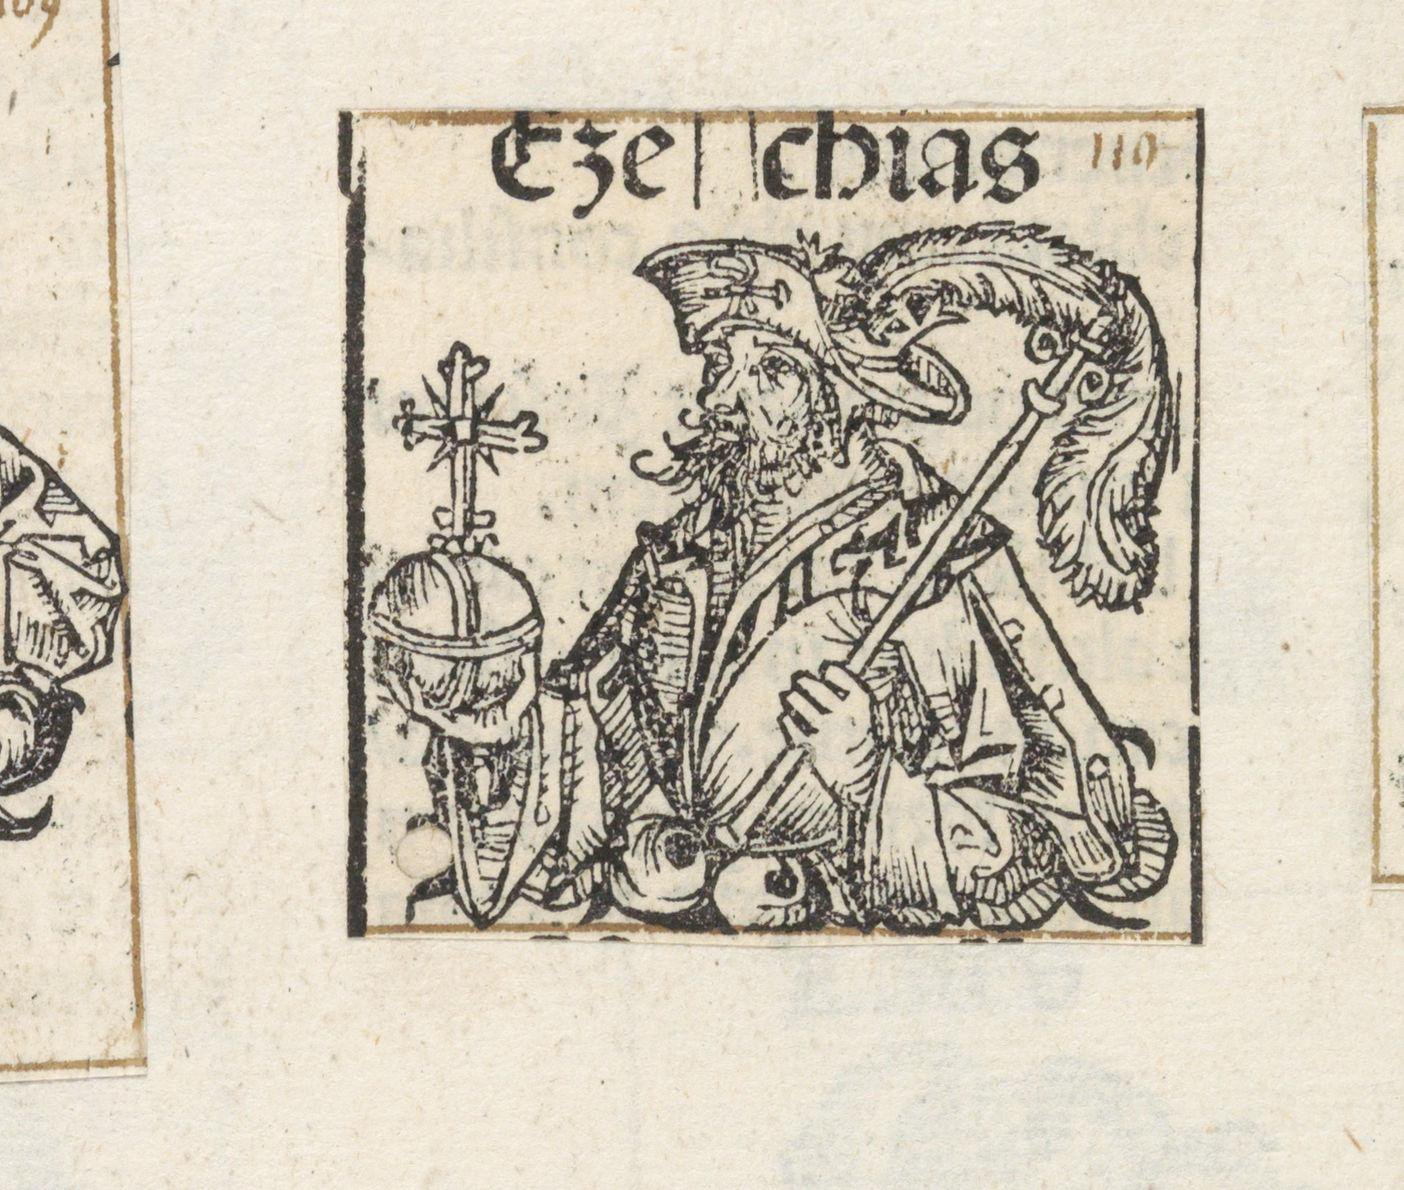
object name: print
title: Ezechias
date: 1493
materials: paper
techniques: letterpress printing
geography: nuremberg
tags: persons from the old testament (not in biblical context, nor occurring in legendary/historical extensions included in division 71)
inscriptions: inscription: ‘110’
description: Een bloemkelk met een man met pluimhoed, rijksappel en scepter. De voorstelling is een fragment van de stamboom van Christus in de Liber Chronicarum. De tekst identificeert hem als Ezechias, de zoon van Achaz. De prent maakt deel uit van een album.